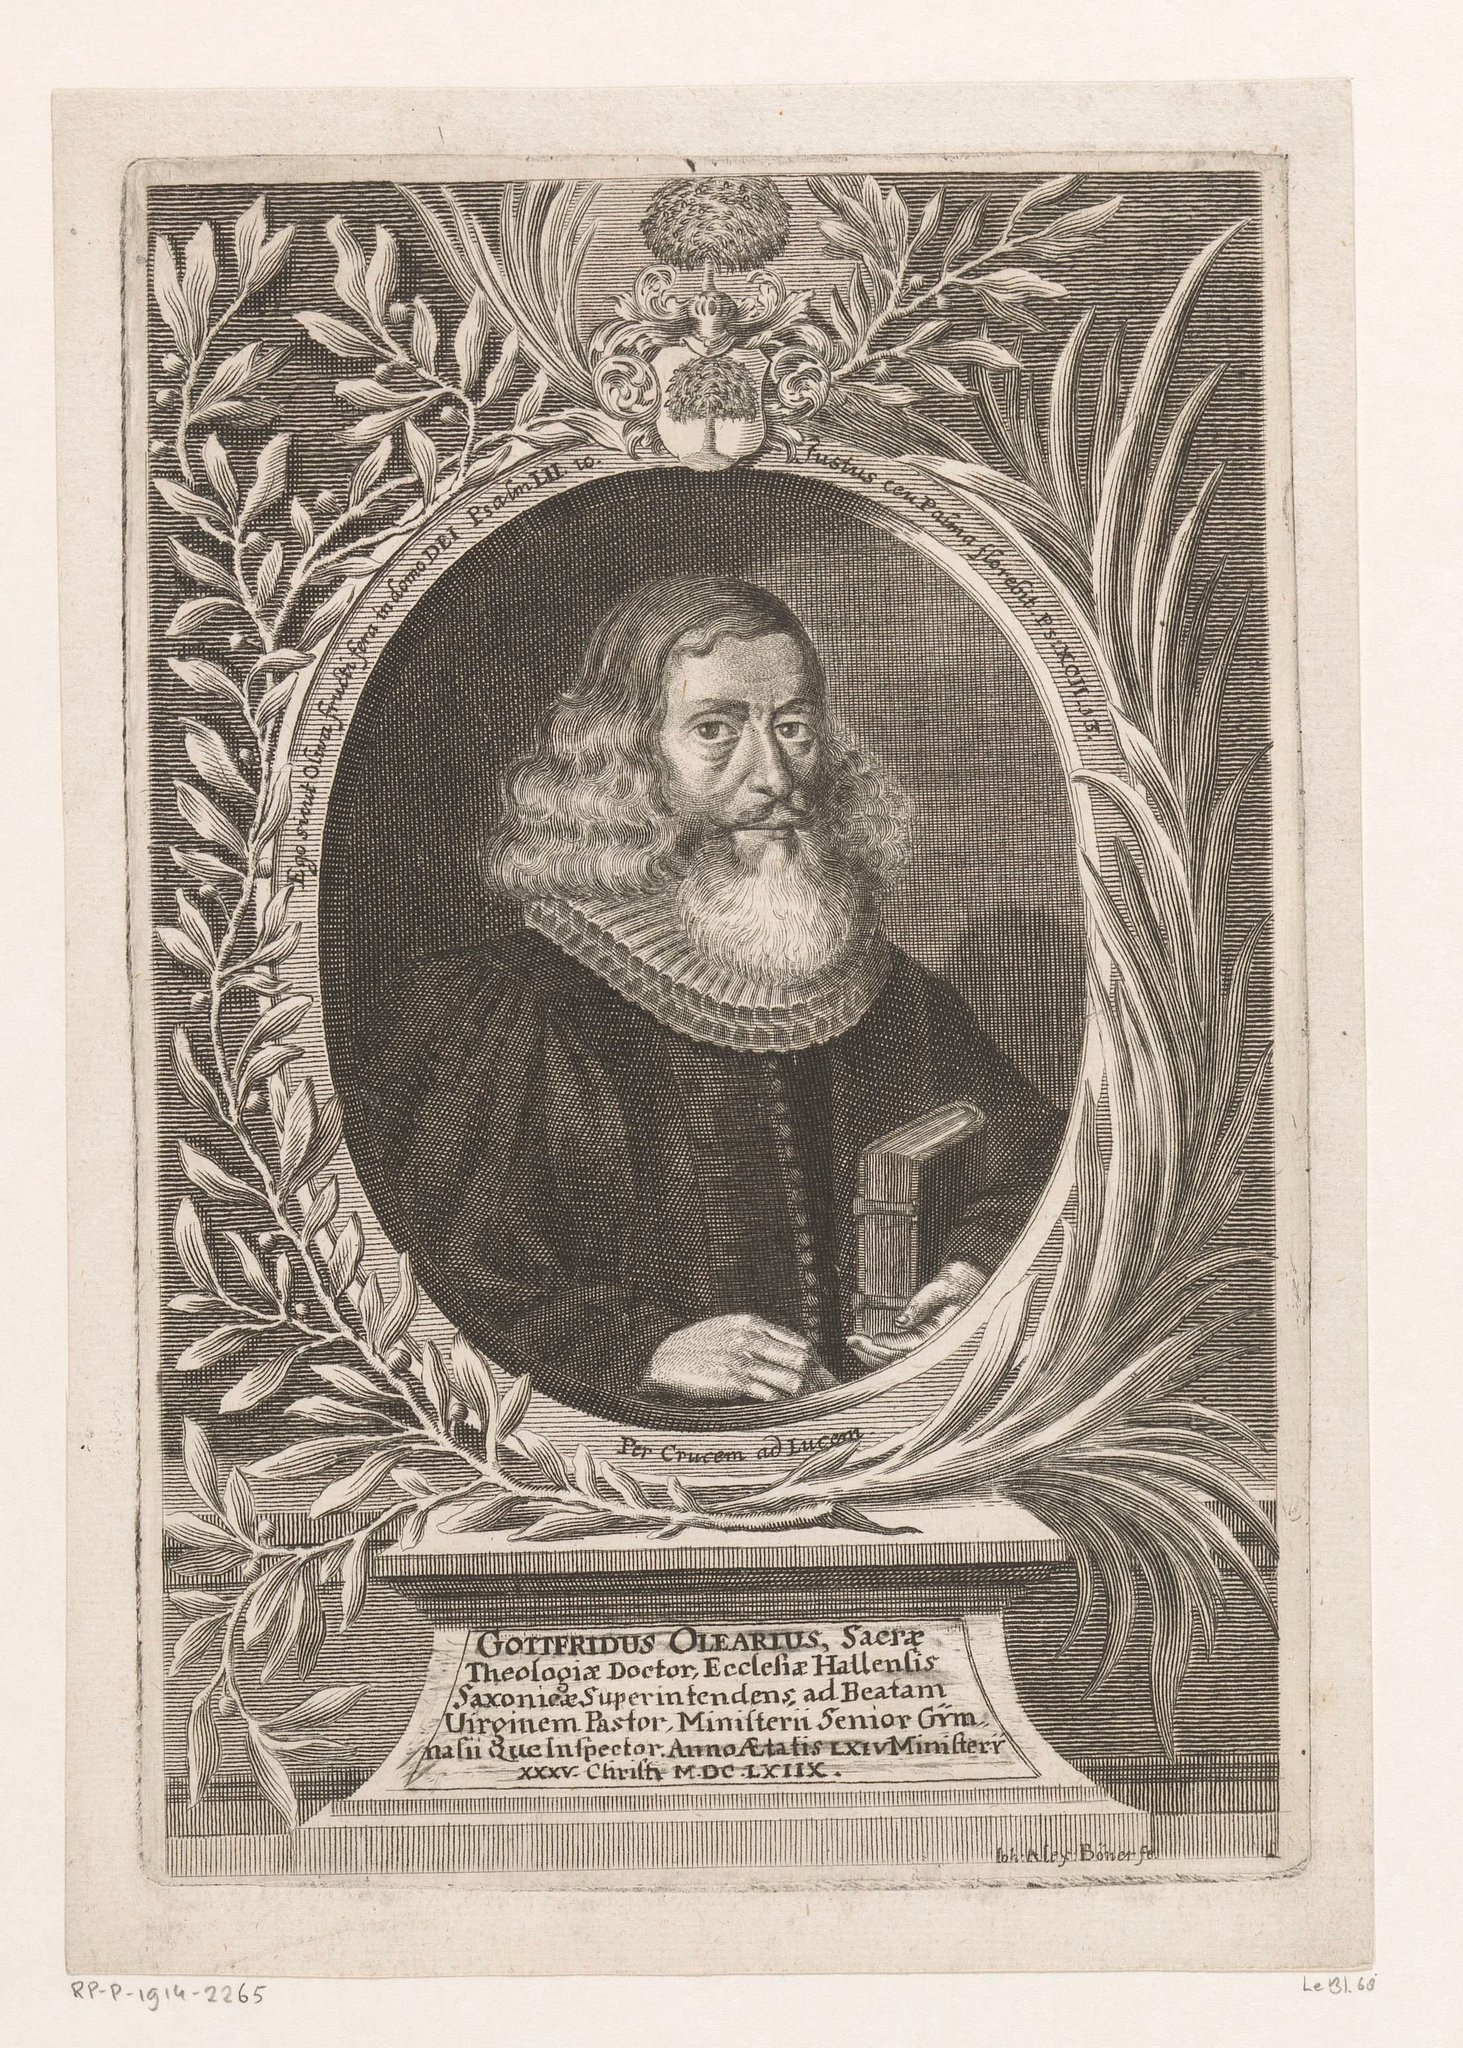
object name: print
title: Portret van Gottfried I Olearius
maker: johann alexander böner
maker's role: draughtsman, print maker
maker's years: 1647-1720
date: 1668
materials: paper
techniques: engraving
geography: nuremberg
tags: historical persons, book, armorial bearing, heraldry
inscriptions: collector's mark: Lugt 2228